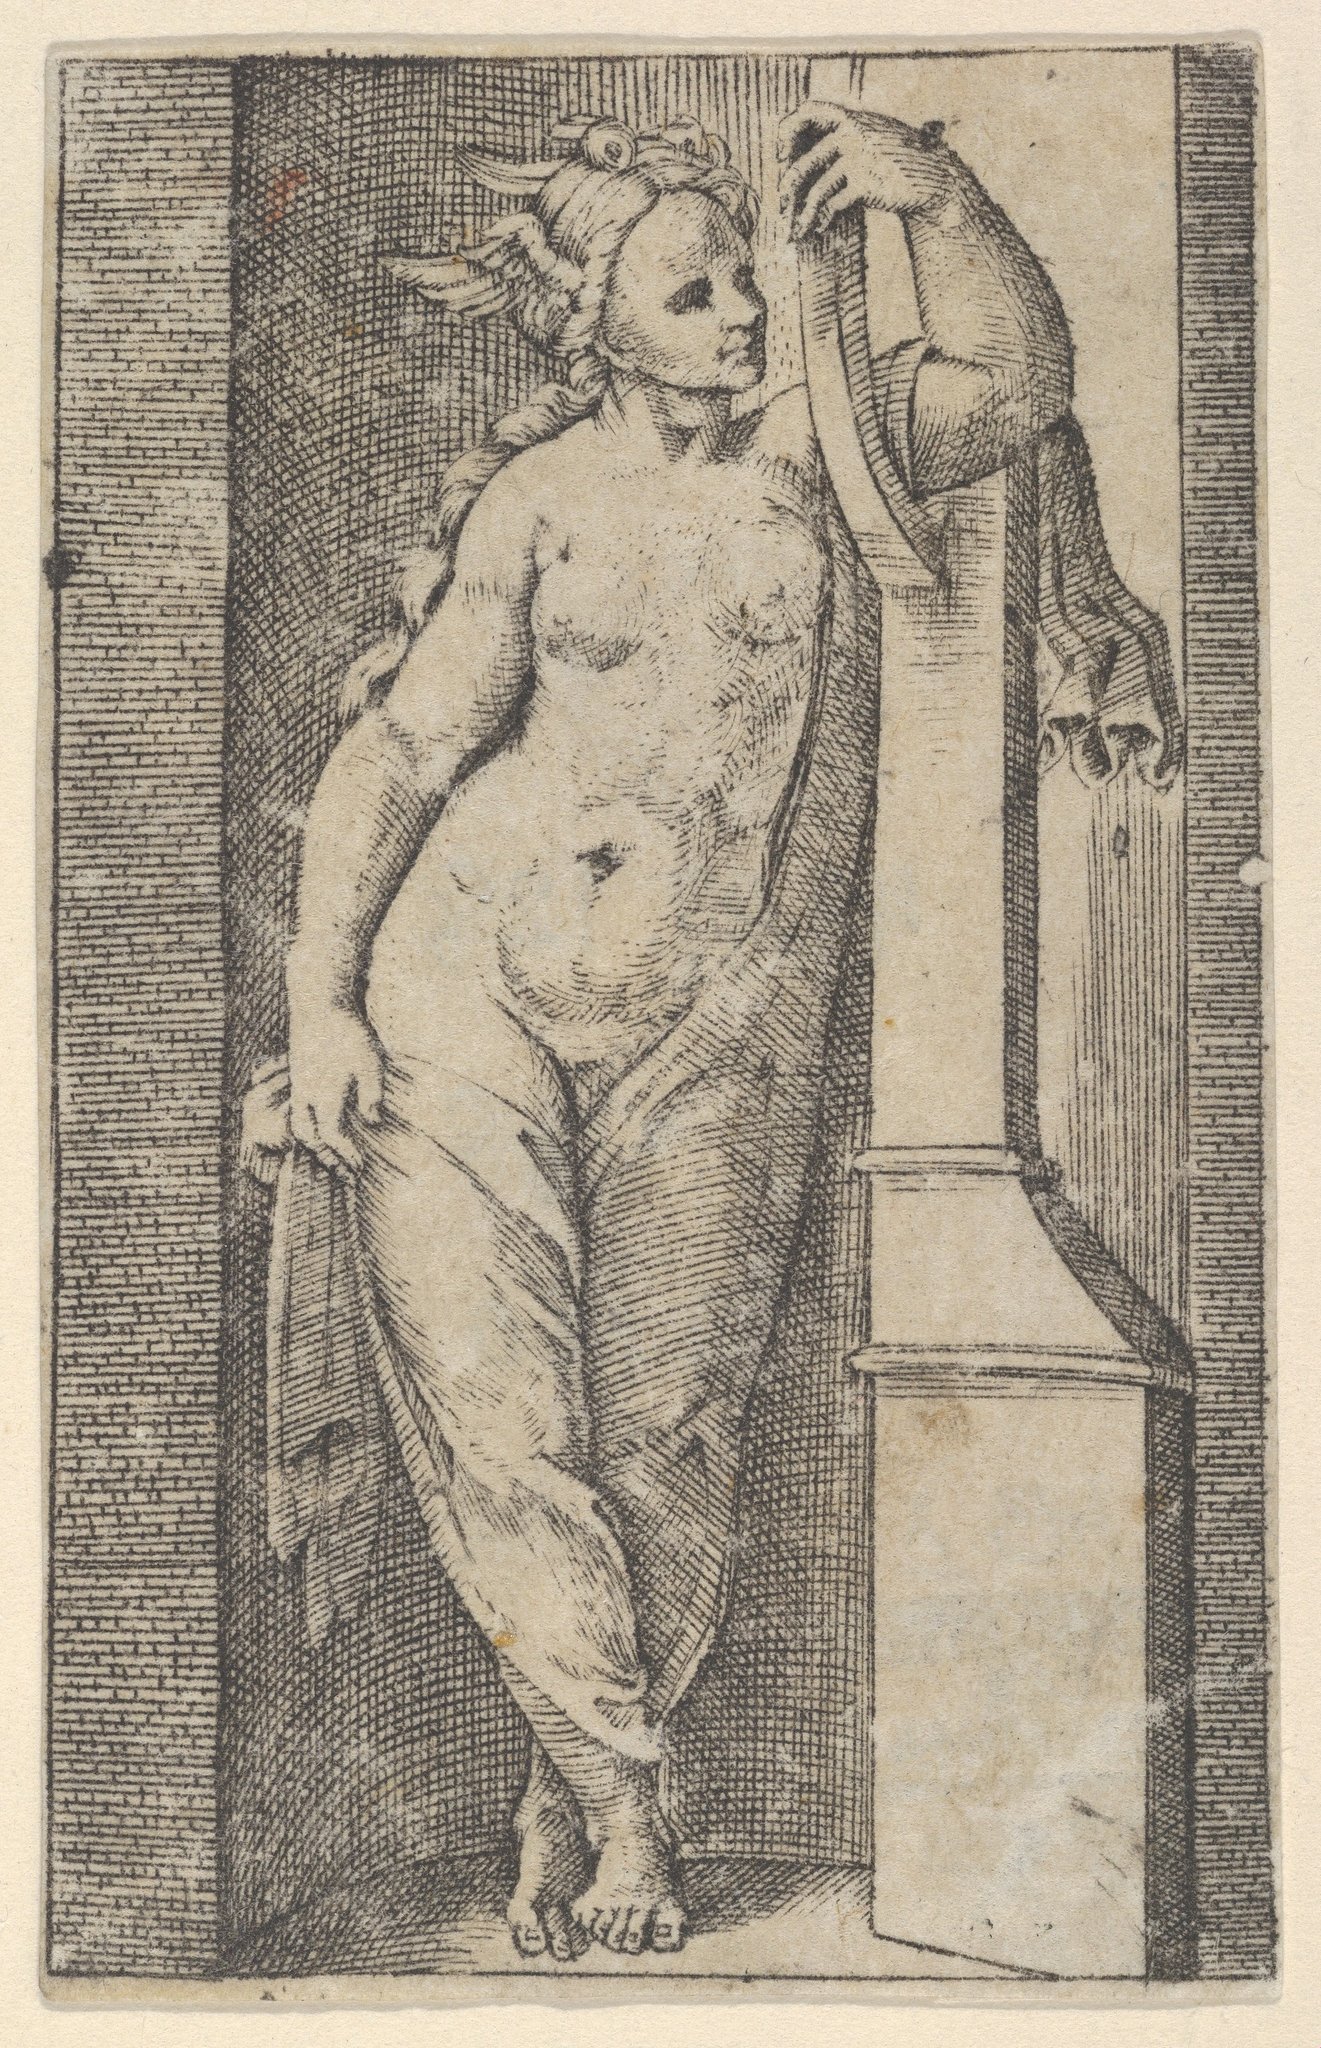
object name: print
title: Woman with a winged head standing in a niche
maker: marcantonio raimondi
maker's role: artist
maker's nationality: italian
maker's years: 1475-1534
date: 1510-1527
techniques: engraving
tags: women